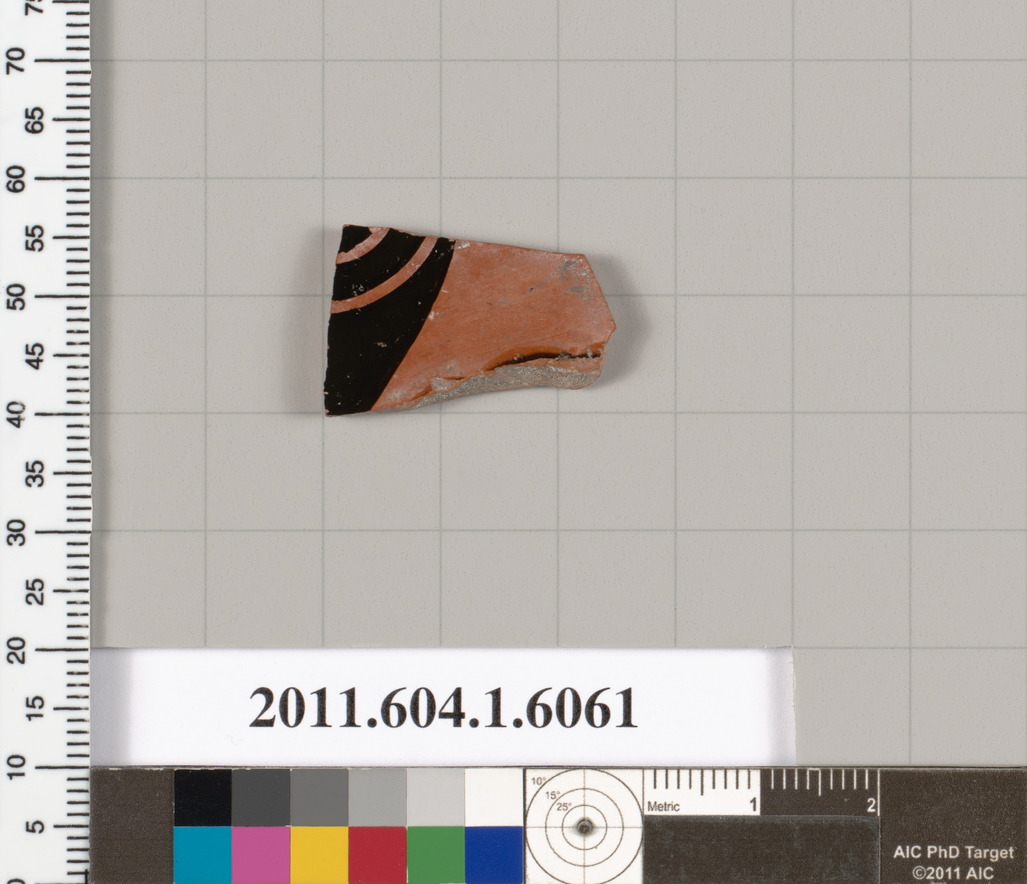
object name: kylix fragment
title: Terracotta fragment of a kylix (drinking cup)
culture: greek, attic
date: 510-500 BCE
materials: terracotta